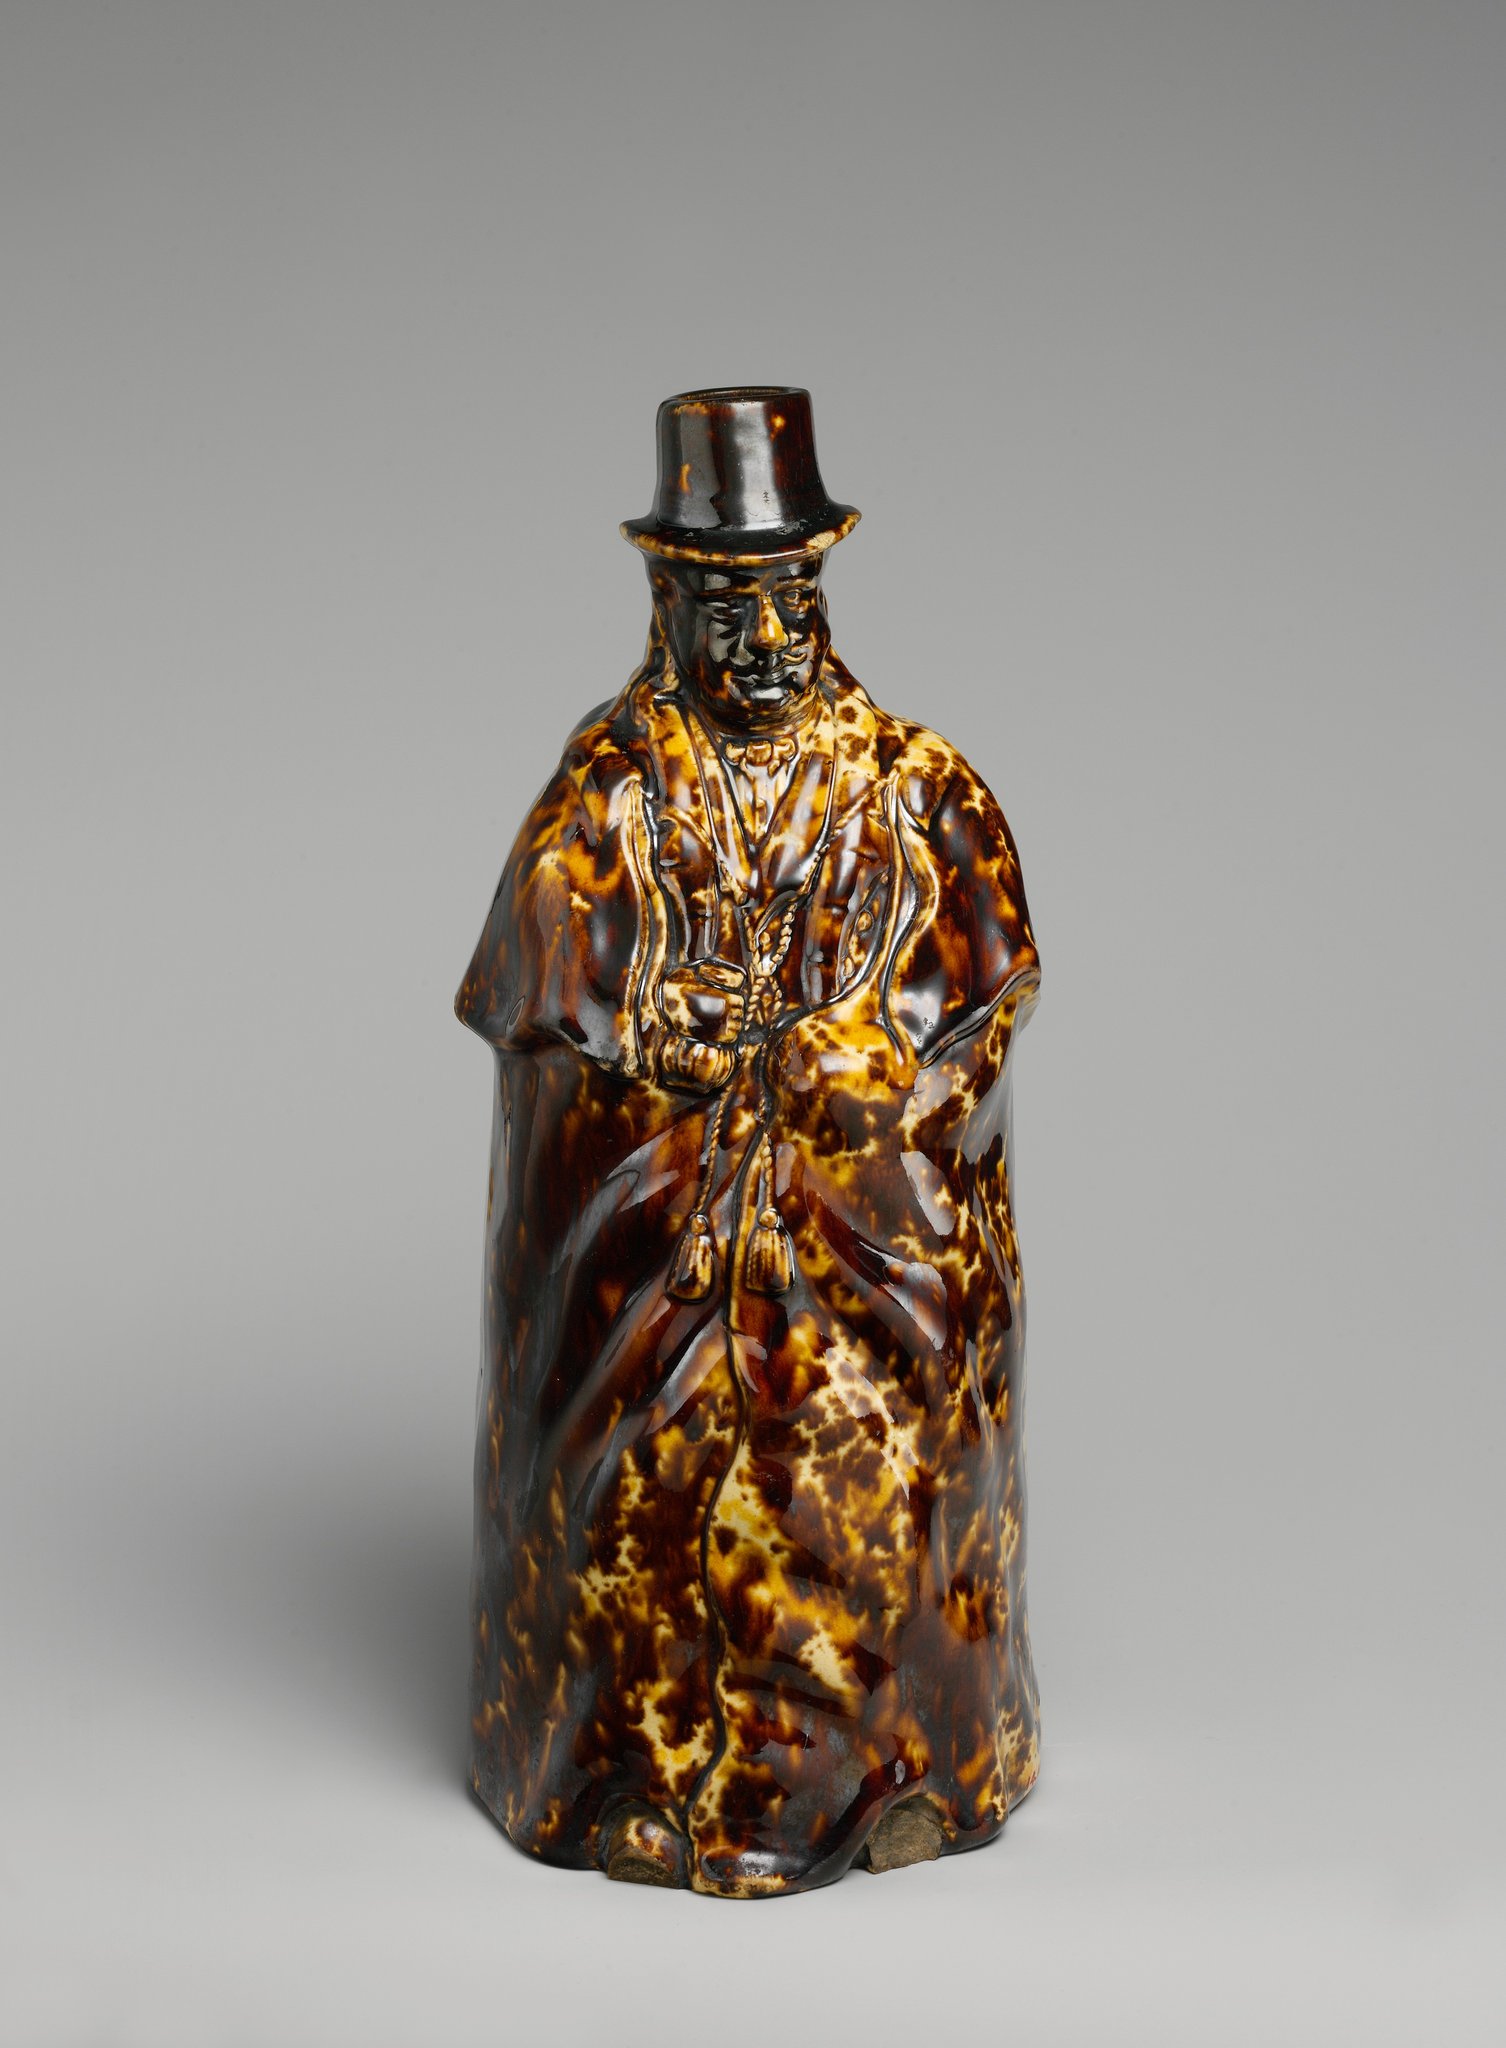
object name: bottle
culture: american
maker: daniel greatbatch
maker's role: designer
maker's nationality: british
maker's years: 1838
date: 1849-1858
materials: earthenware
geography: united states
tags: men